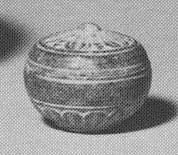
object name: reliquary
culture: gandhara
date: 1-100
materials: stone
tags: gandhara